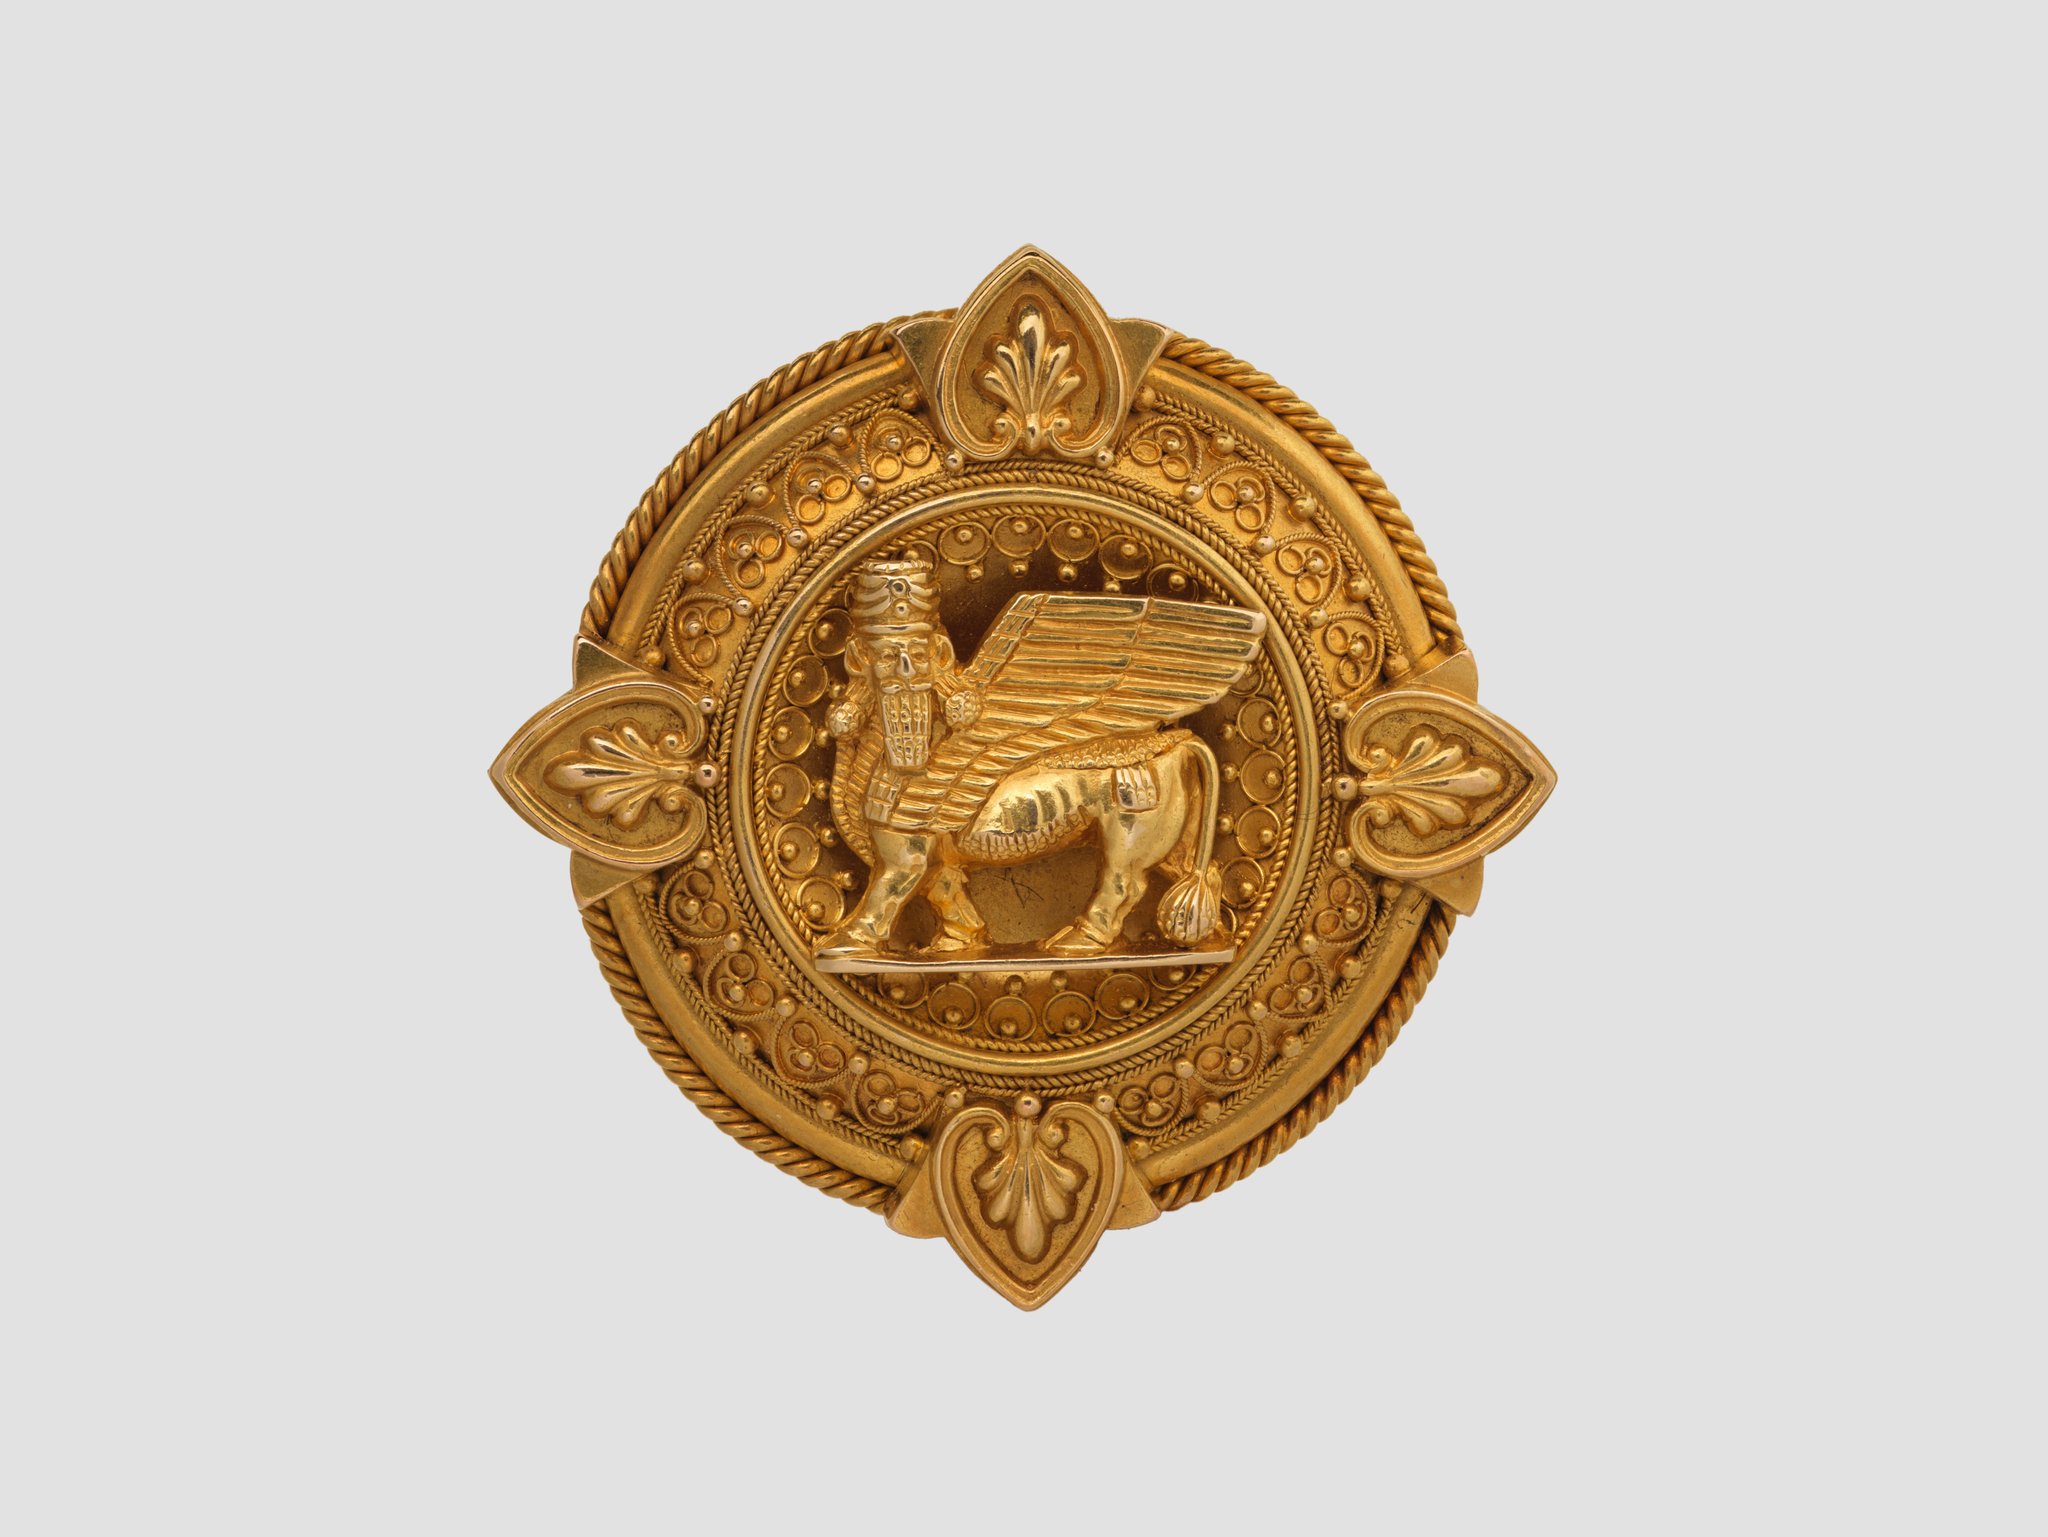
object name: brooch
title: Brooch with Assyrian human-headed winged bull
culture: british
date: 1868-1880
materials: glass, gold